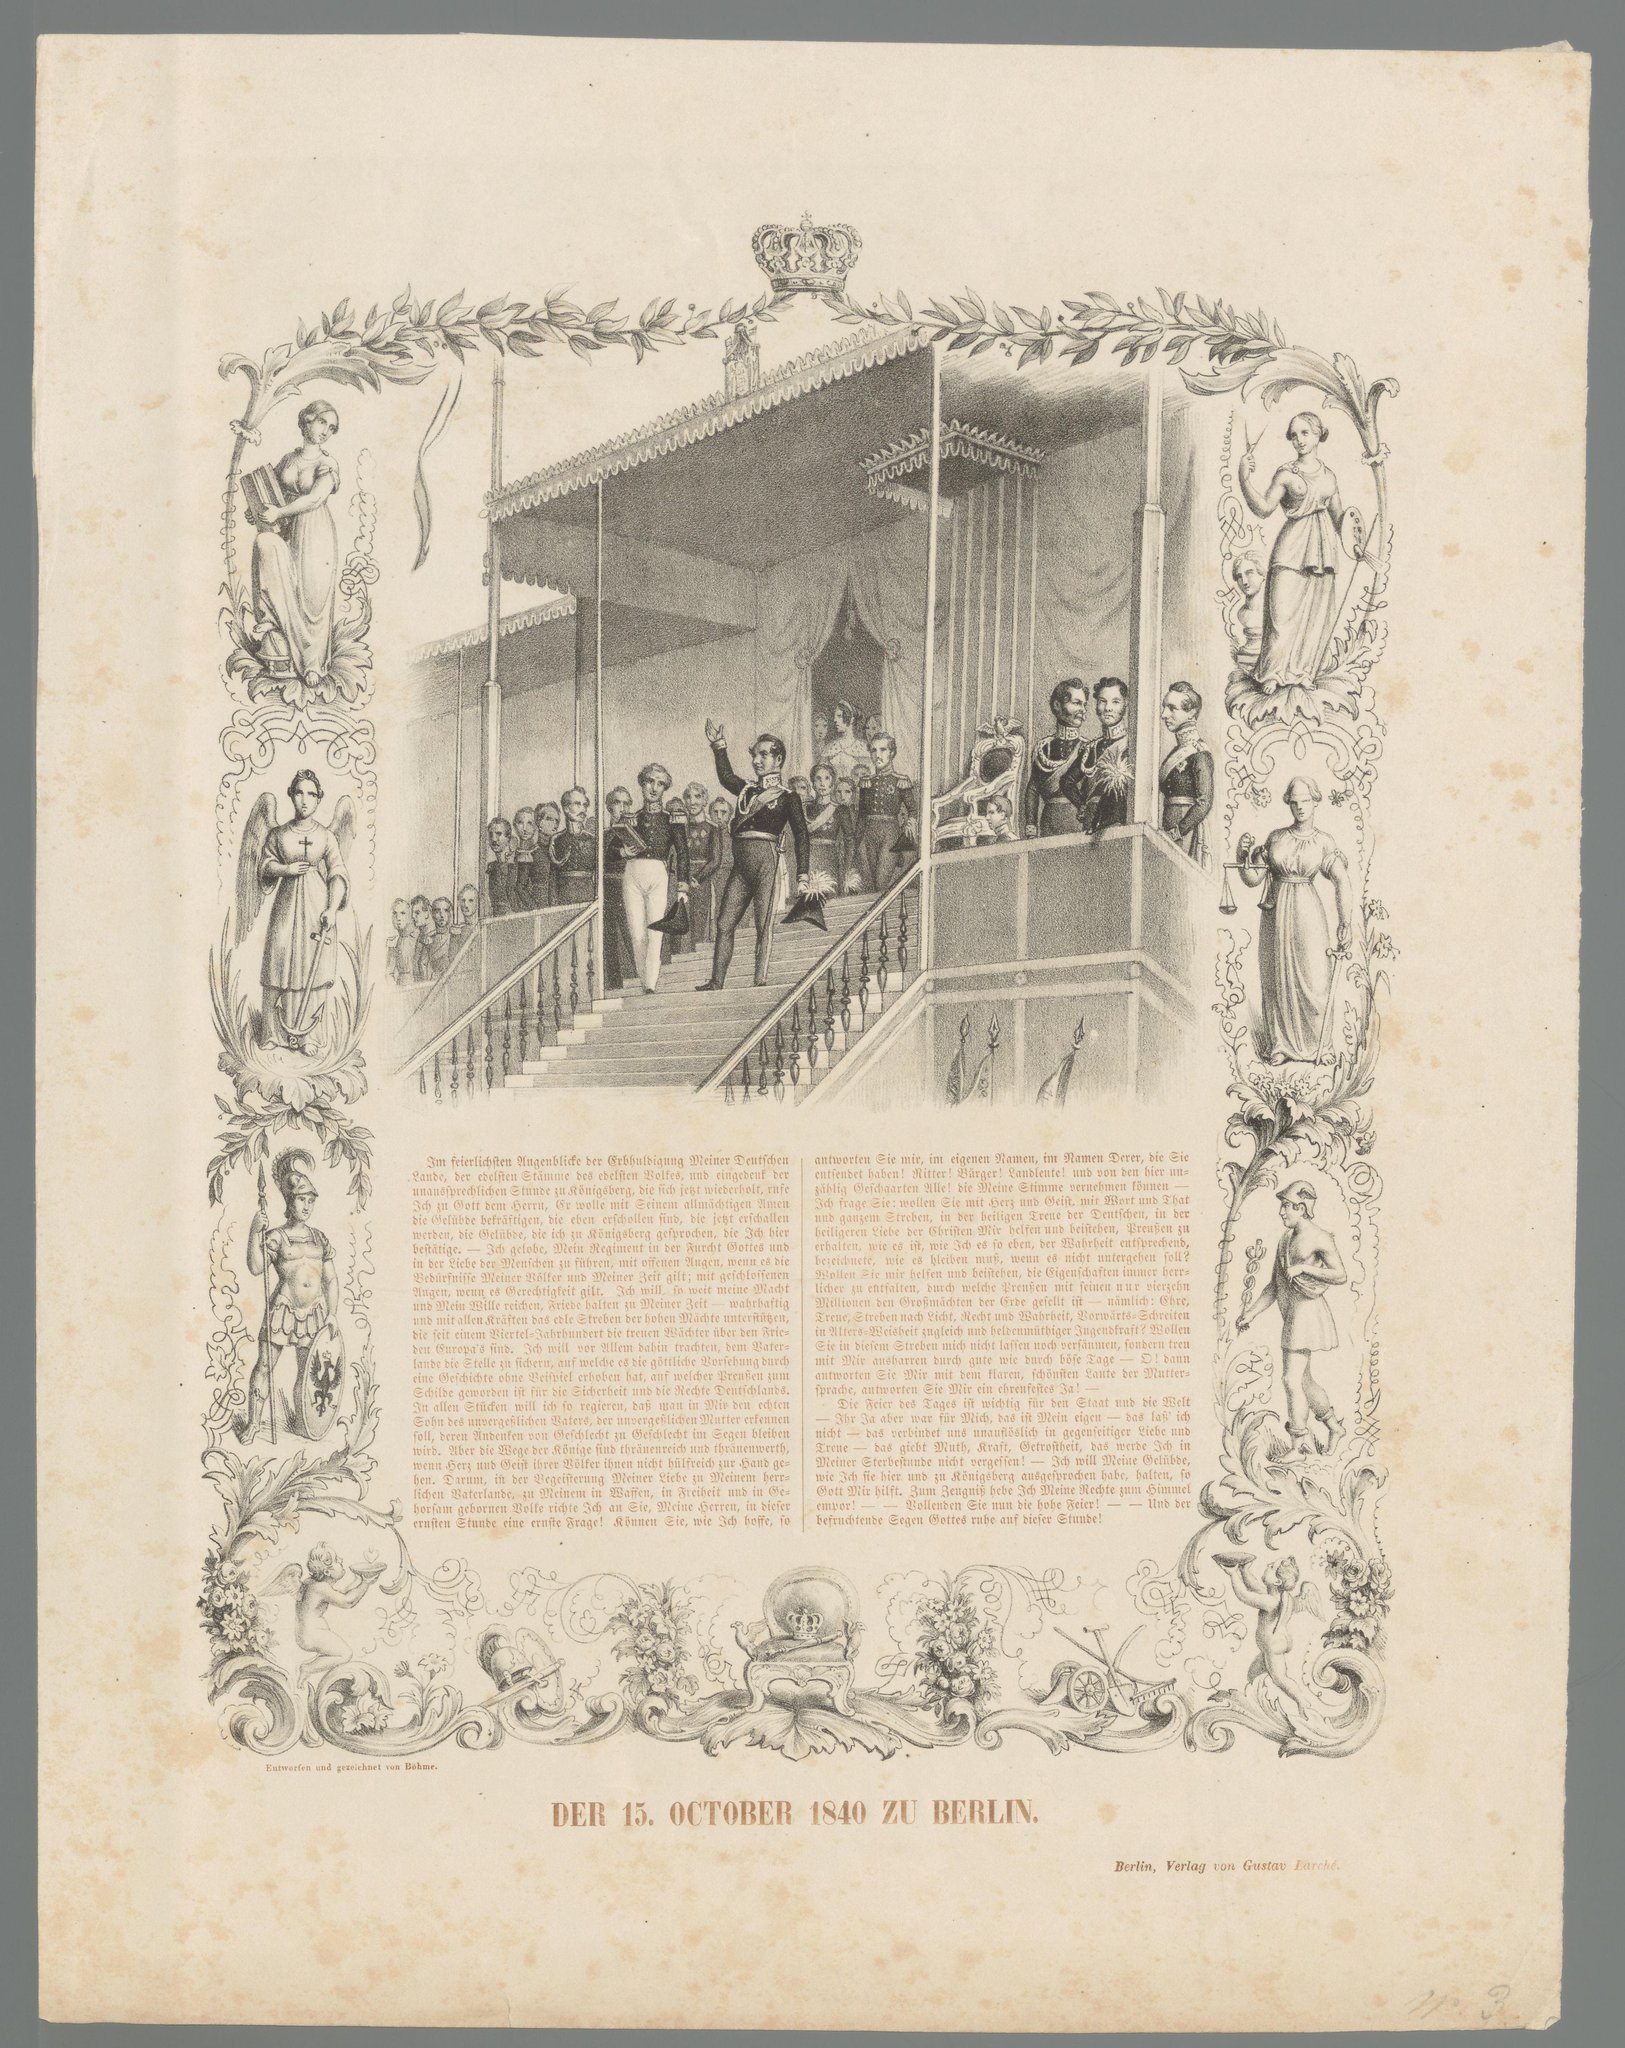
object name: print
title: Redevoering van Frederik Willem IV te Berlijn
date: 1840-1850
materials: paper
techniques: lithograph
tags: berlin, frederik willem iv (koning van pruisen), staircase, person addressing a group, orator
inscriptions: collector's mark: Lugt 2228